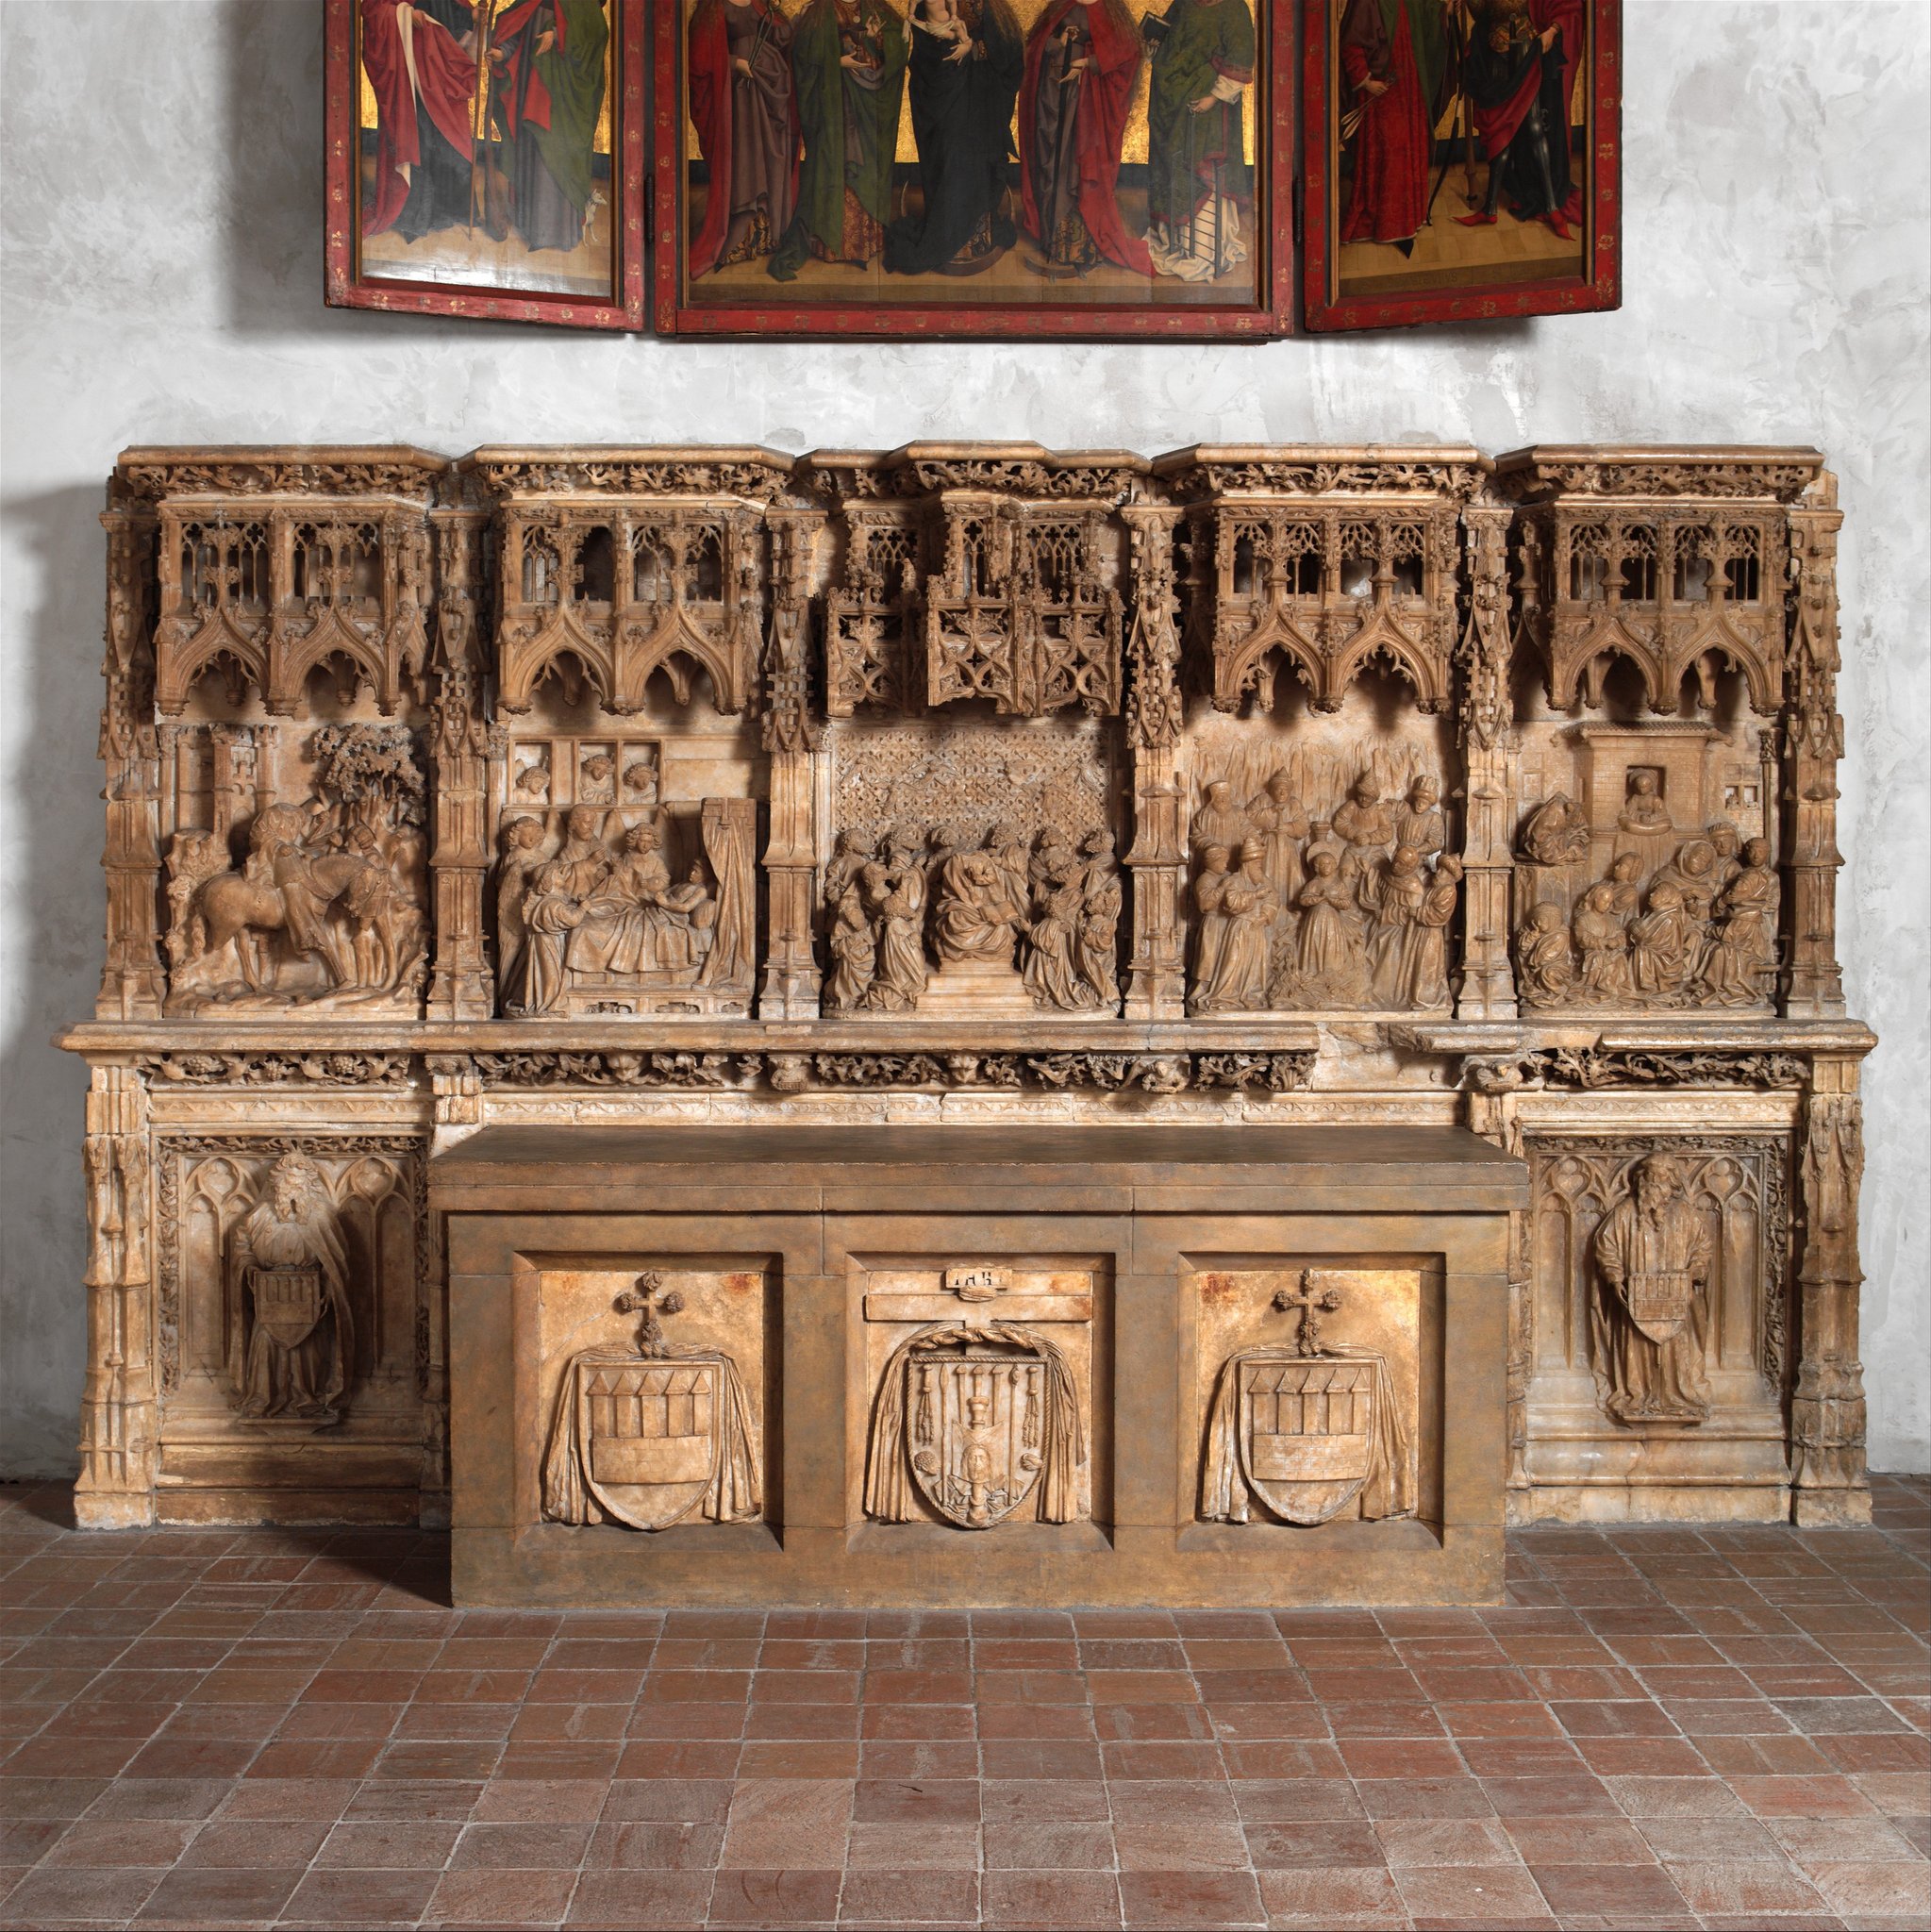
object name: altarpiece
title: Altar Predella and Socle of Archbishop Don Dalmau de Mur y Cervelló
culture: spanish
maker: francí gomar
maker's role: artist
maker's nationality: spanish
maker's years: 1443-1493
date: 1456-1458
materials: alabaster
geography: spain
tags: saint paul